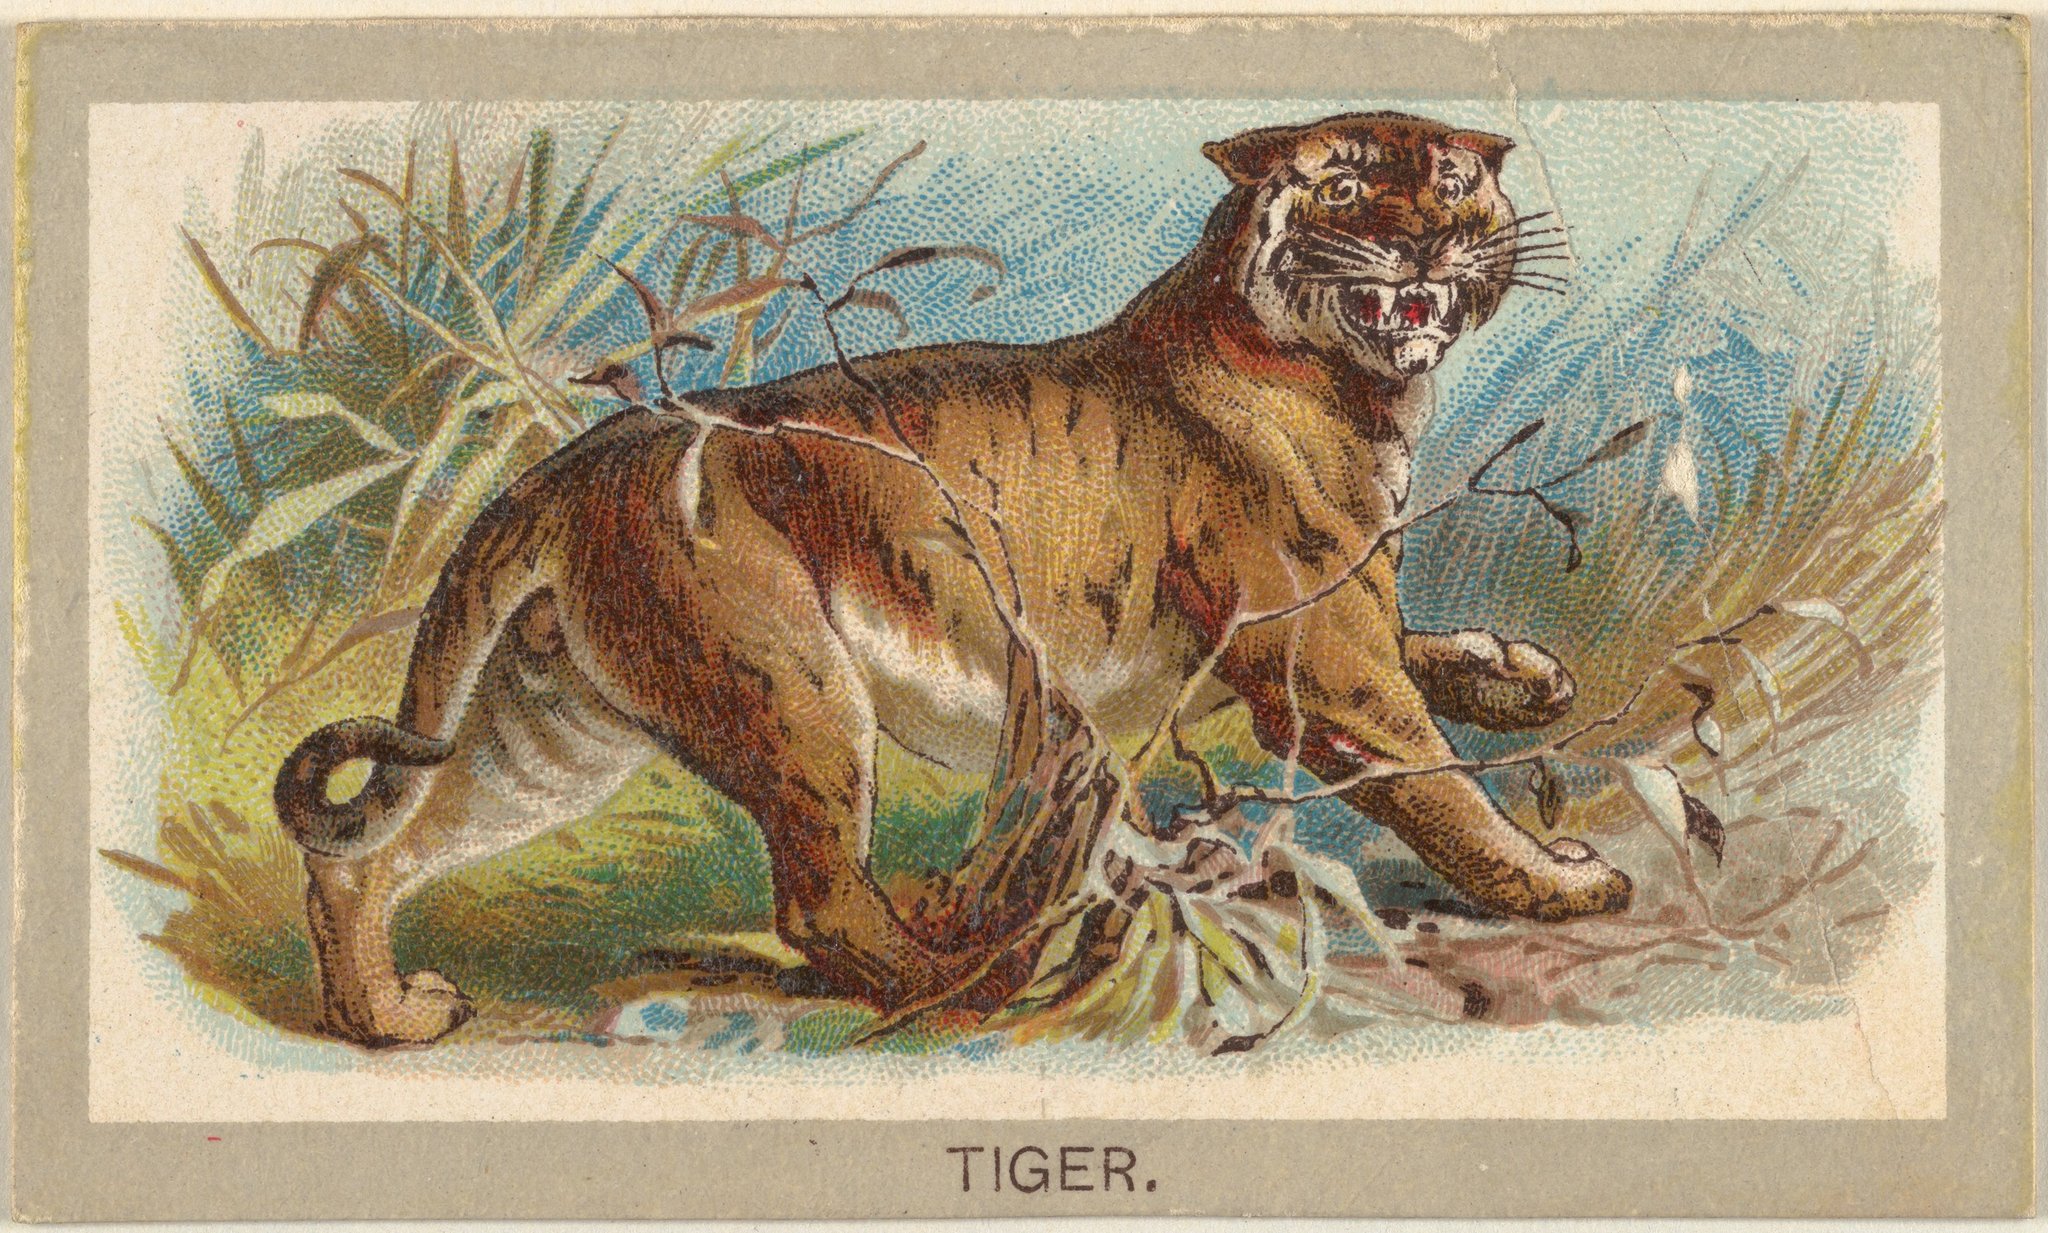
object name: print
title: Tiger, from the Animals of the World series (T180), issued by Abdul Cigarettes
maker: abdul cigarettes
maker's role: publisher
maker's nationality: american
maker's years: 1881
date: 1881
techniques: color lithograph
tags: tigers